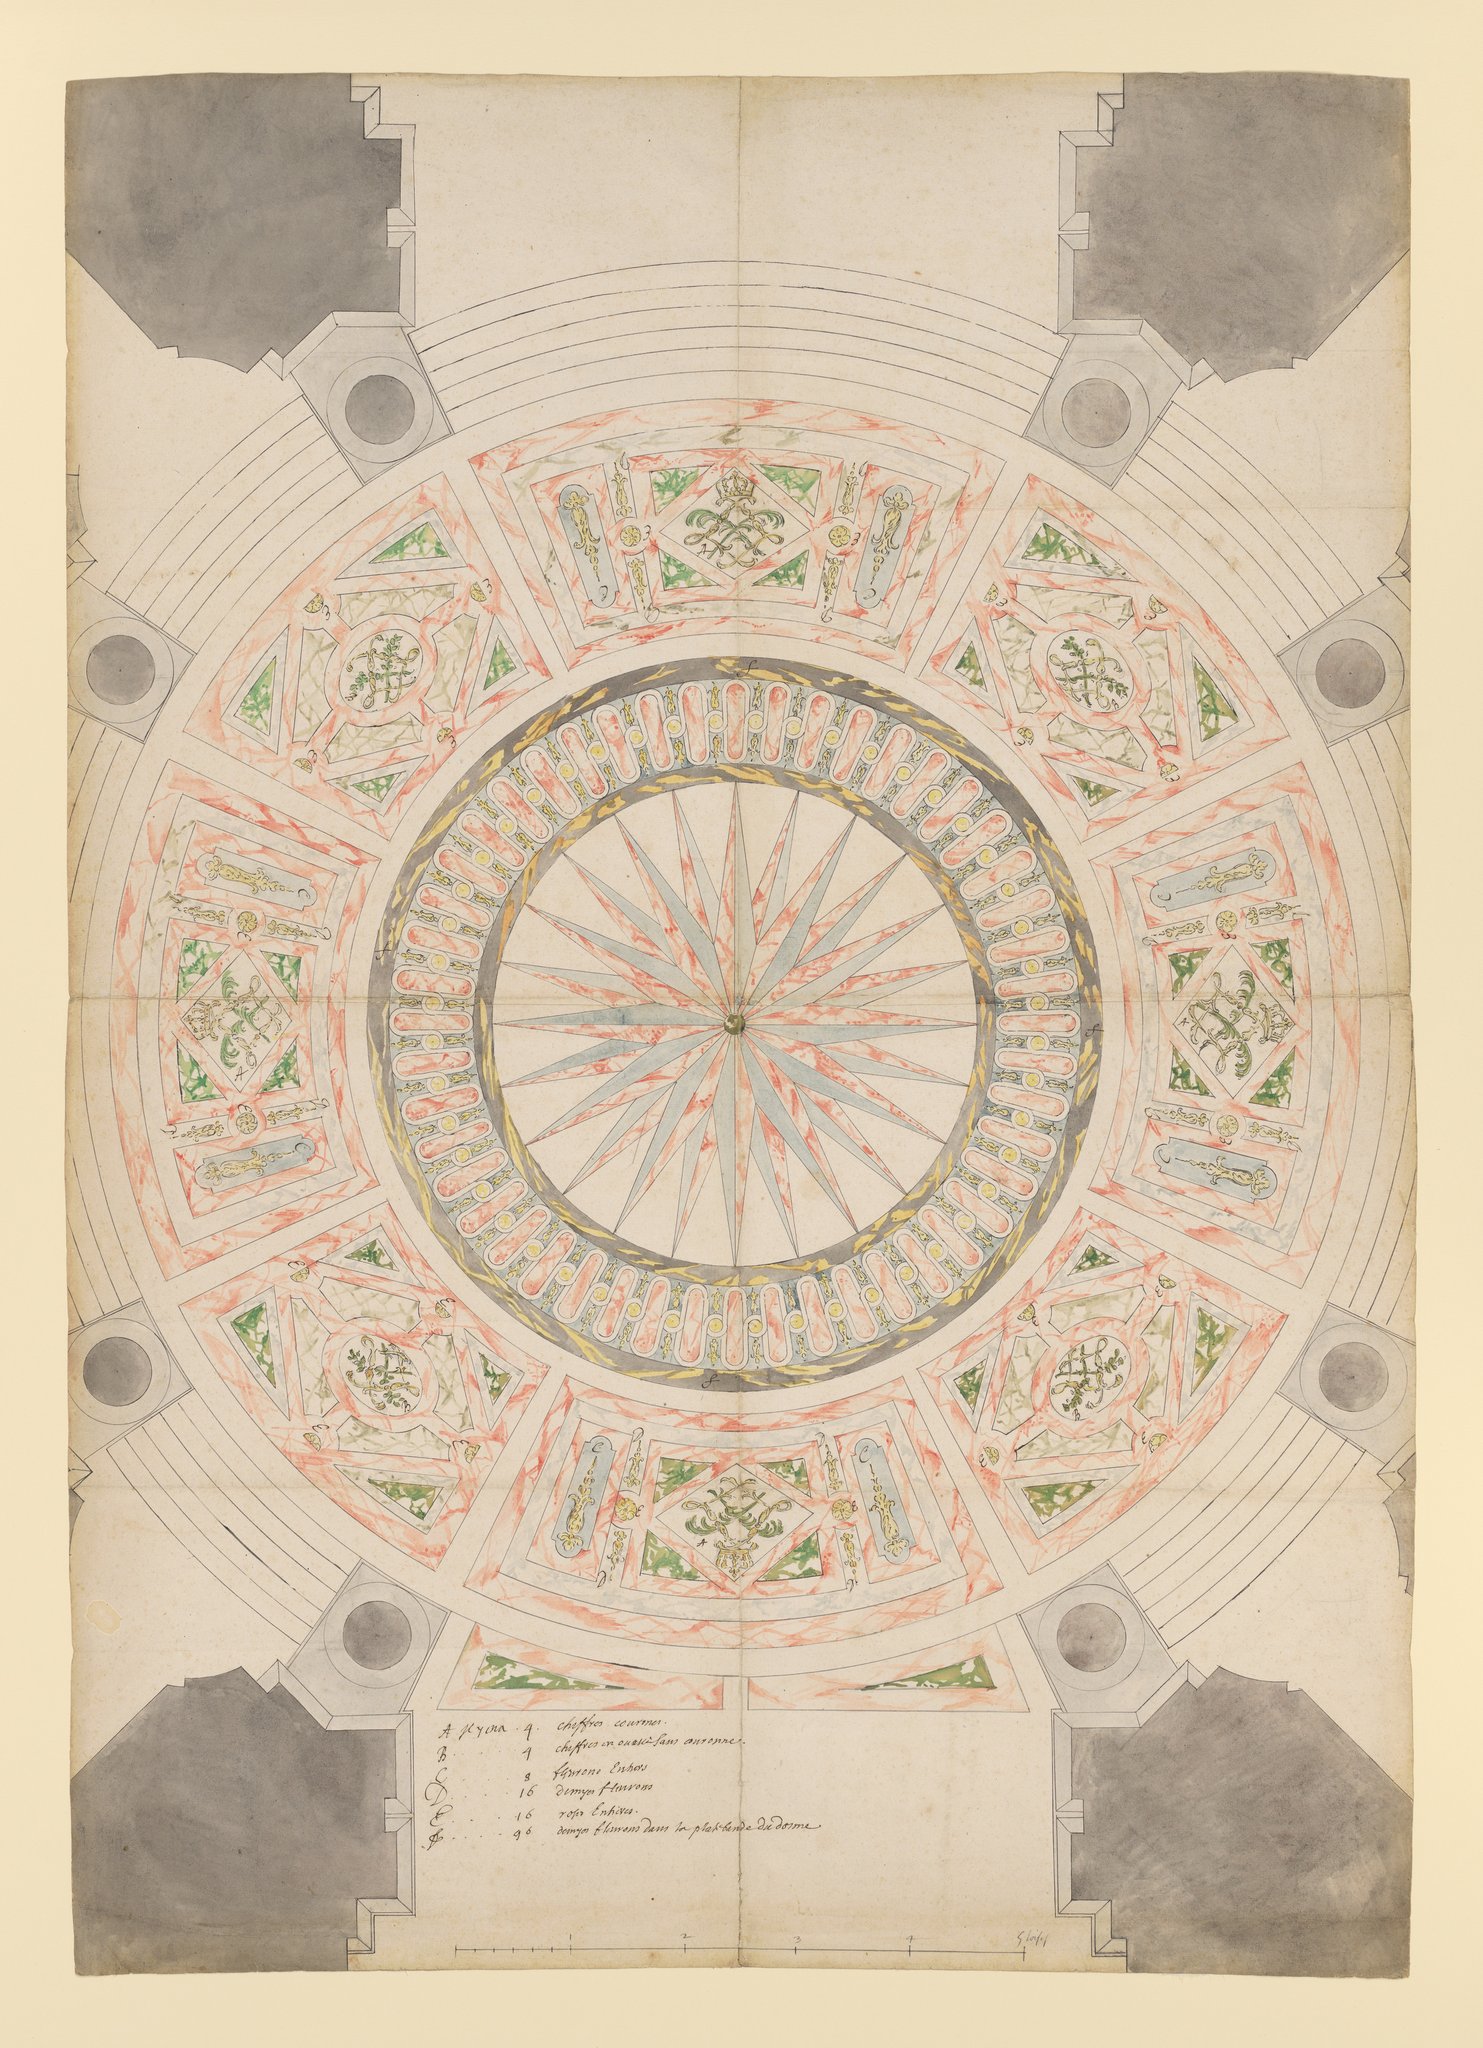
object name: drawing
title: Design for the Marble Floor of the Dôme des Invalides, Paris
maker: jules hardouin mansart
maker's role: artist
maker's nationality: french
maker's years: 1646-1708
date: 1691-1698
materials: graphite, ink, watercolor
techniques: pen